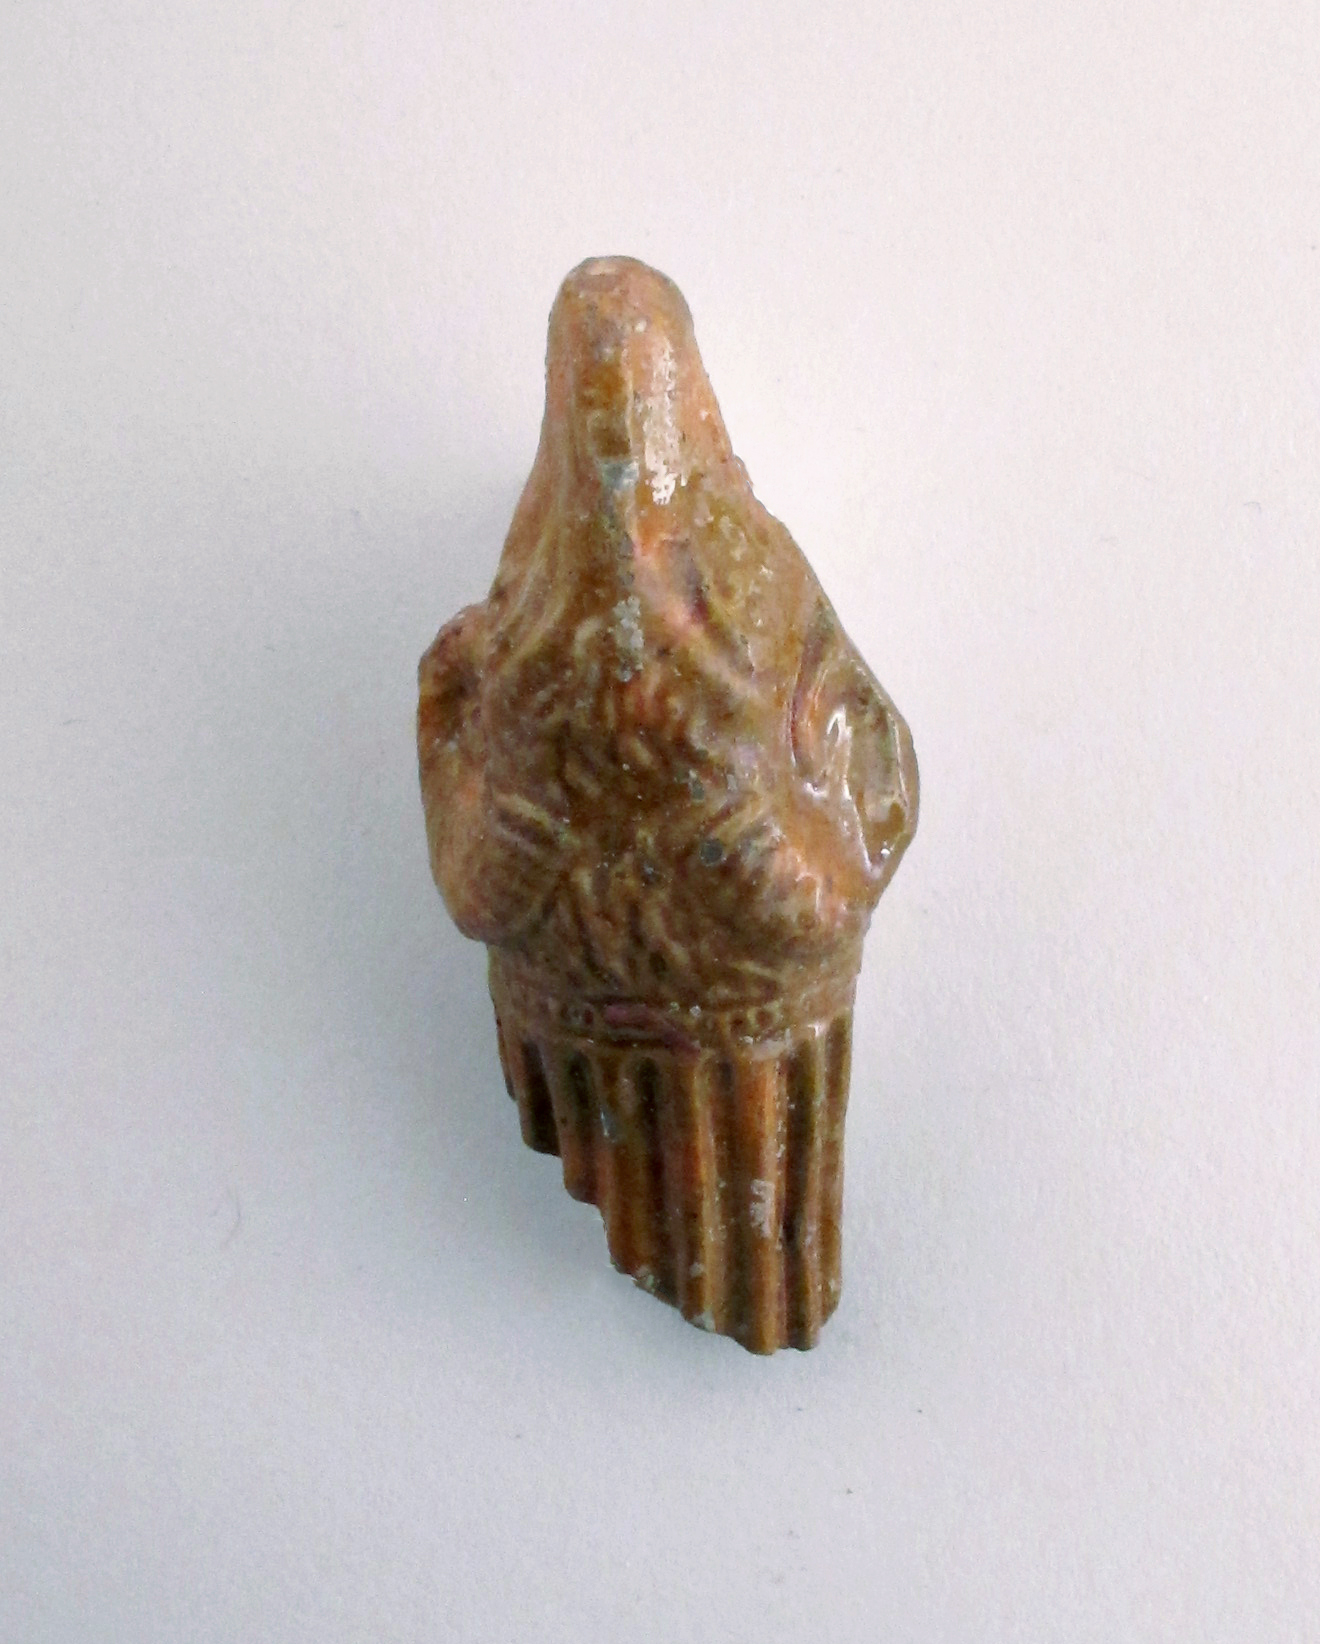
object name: vase fragment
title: Glazed terracotta handle fragment from a saucepan (patera)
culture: roman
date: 67-100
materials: terracotta